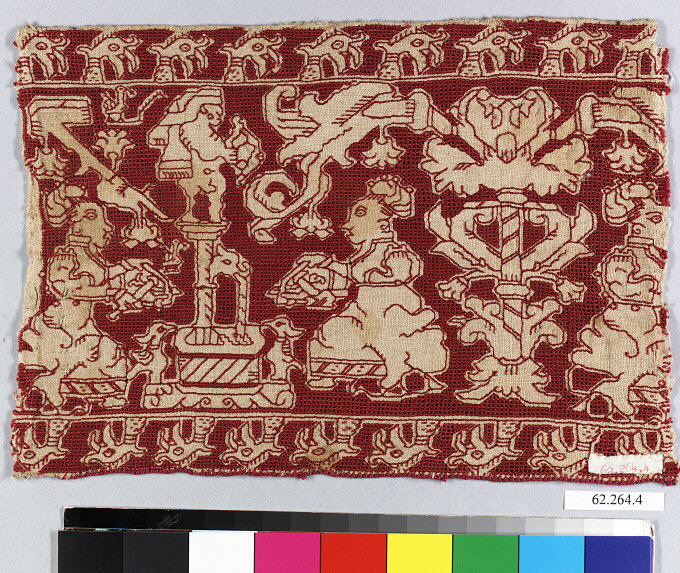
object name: band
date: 1501-1600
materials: linen, silk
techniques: embroidery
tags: human figures